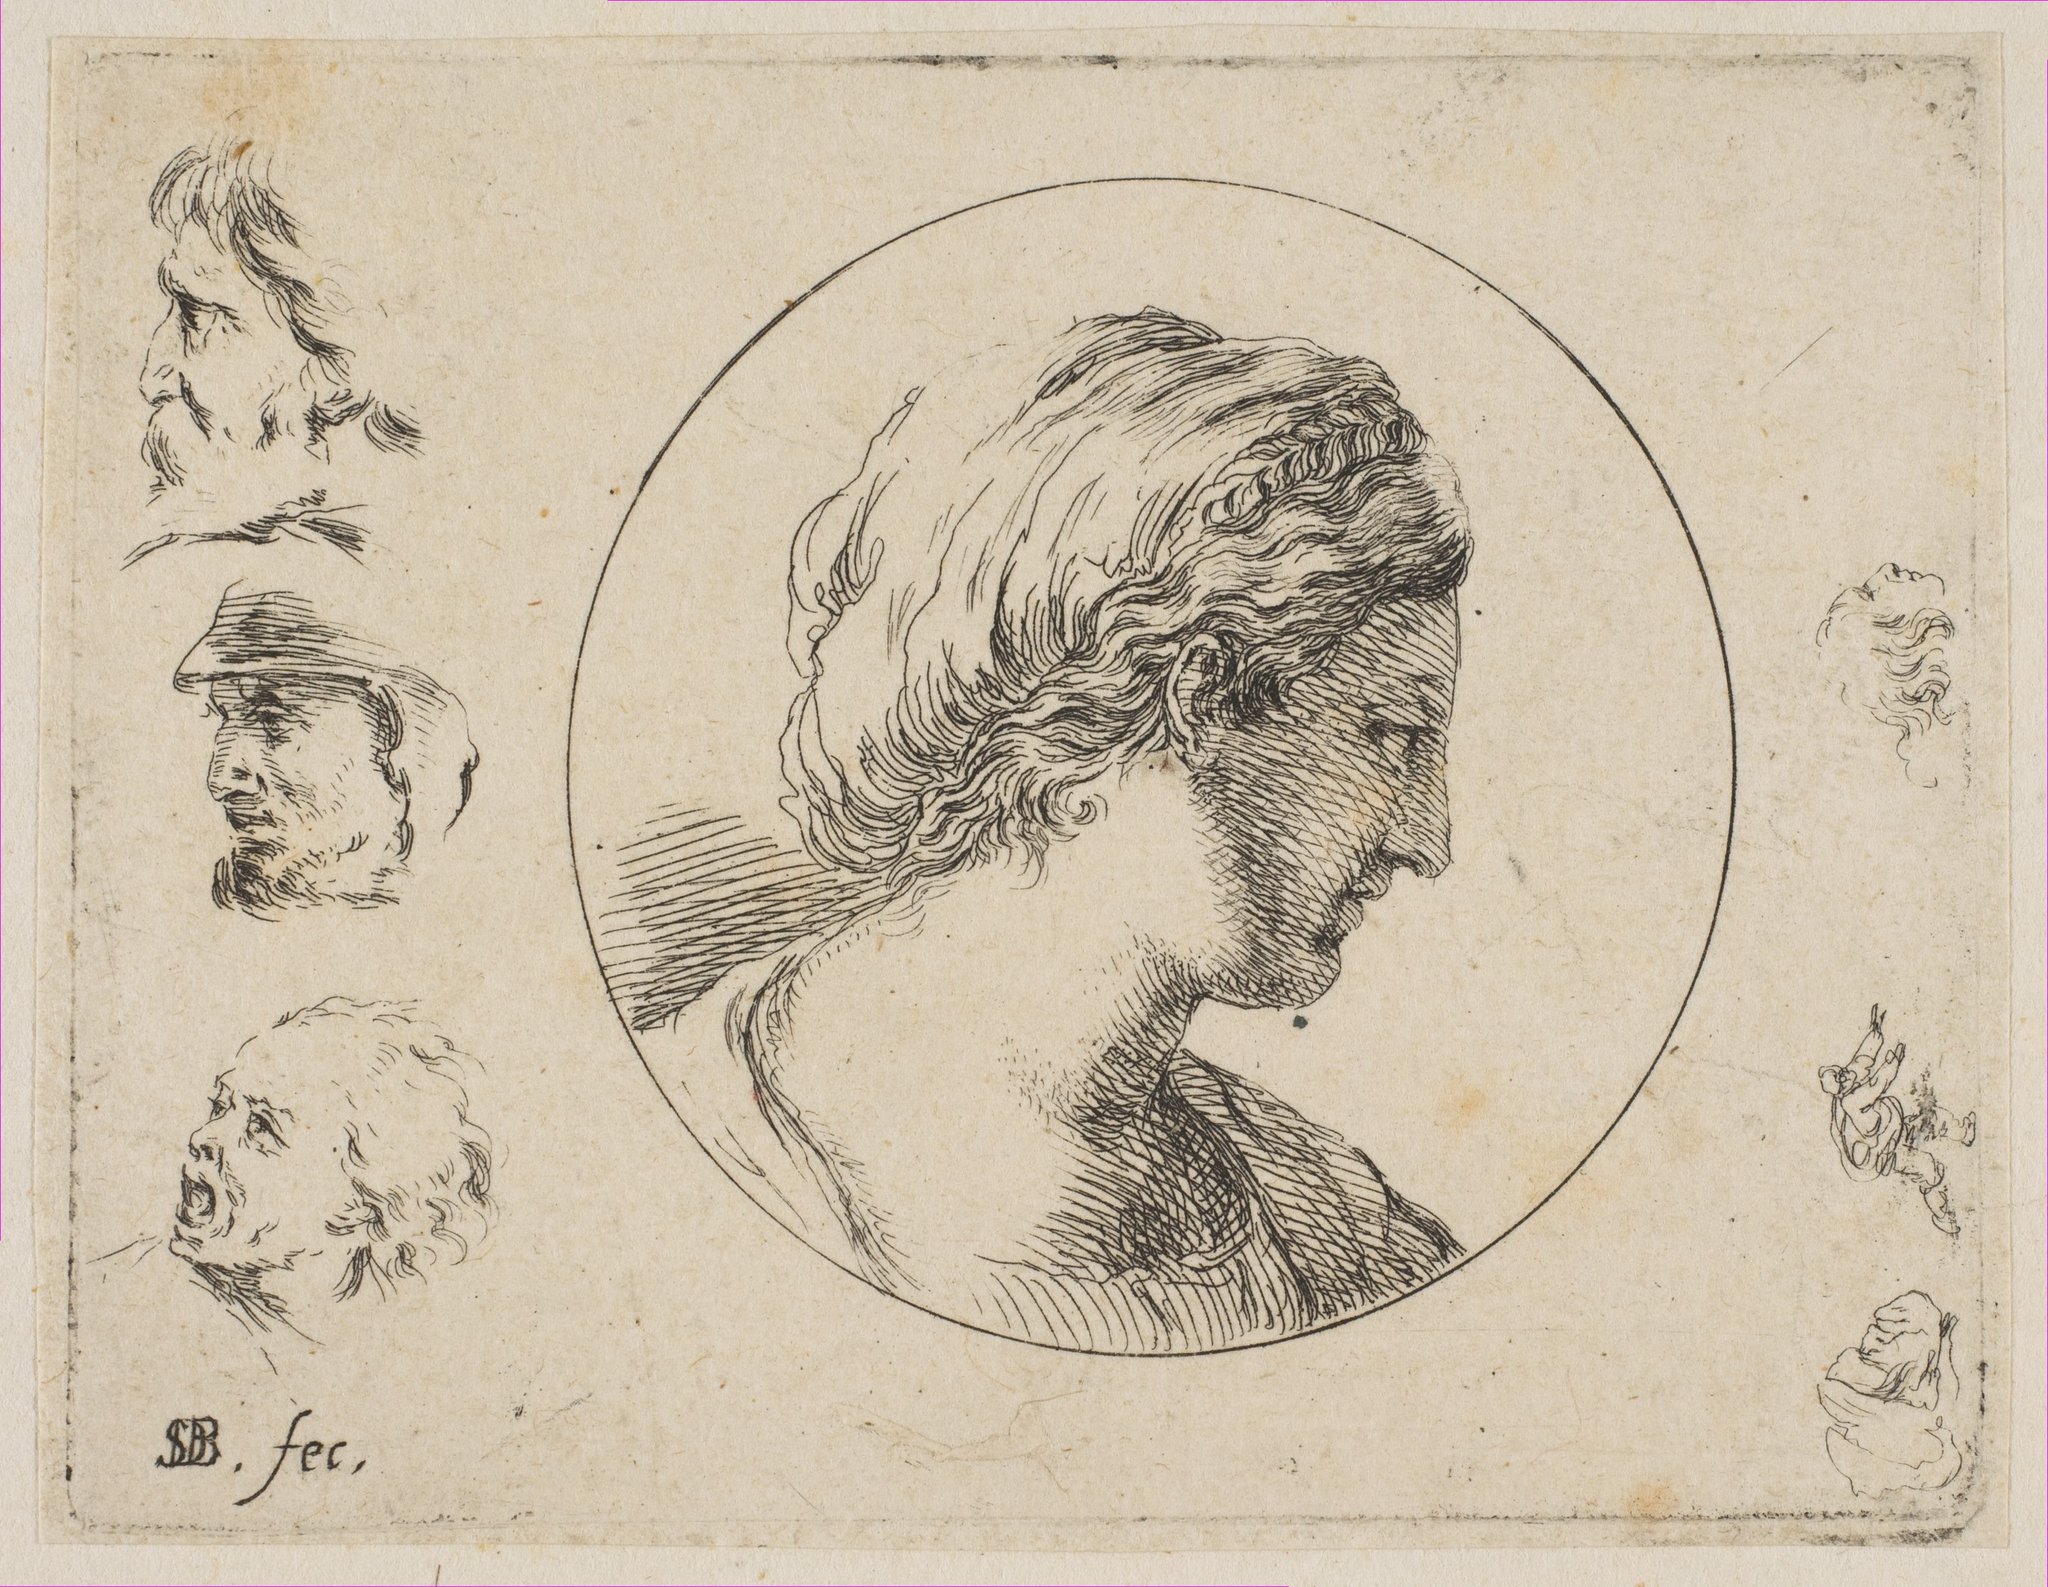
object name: print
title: Plate 4: Head of a Woman in Profile, from 'Second collection of various doodles and etching proofs' (Second recueil de divers griffonnements et preuves d'eauforte)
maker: stefano della bella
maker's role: artist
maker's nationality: italian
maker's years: 1610-1664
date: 1646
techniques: etching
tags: men,profiles,women